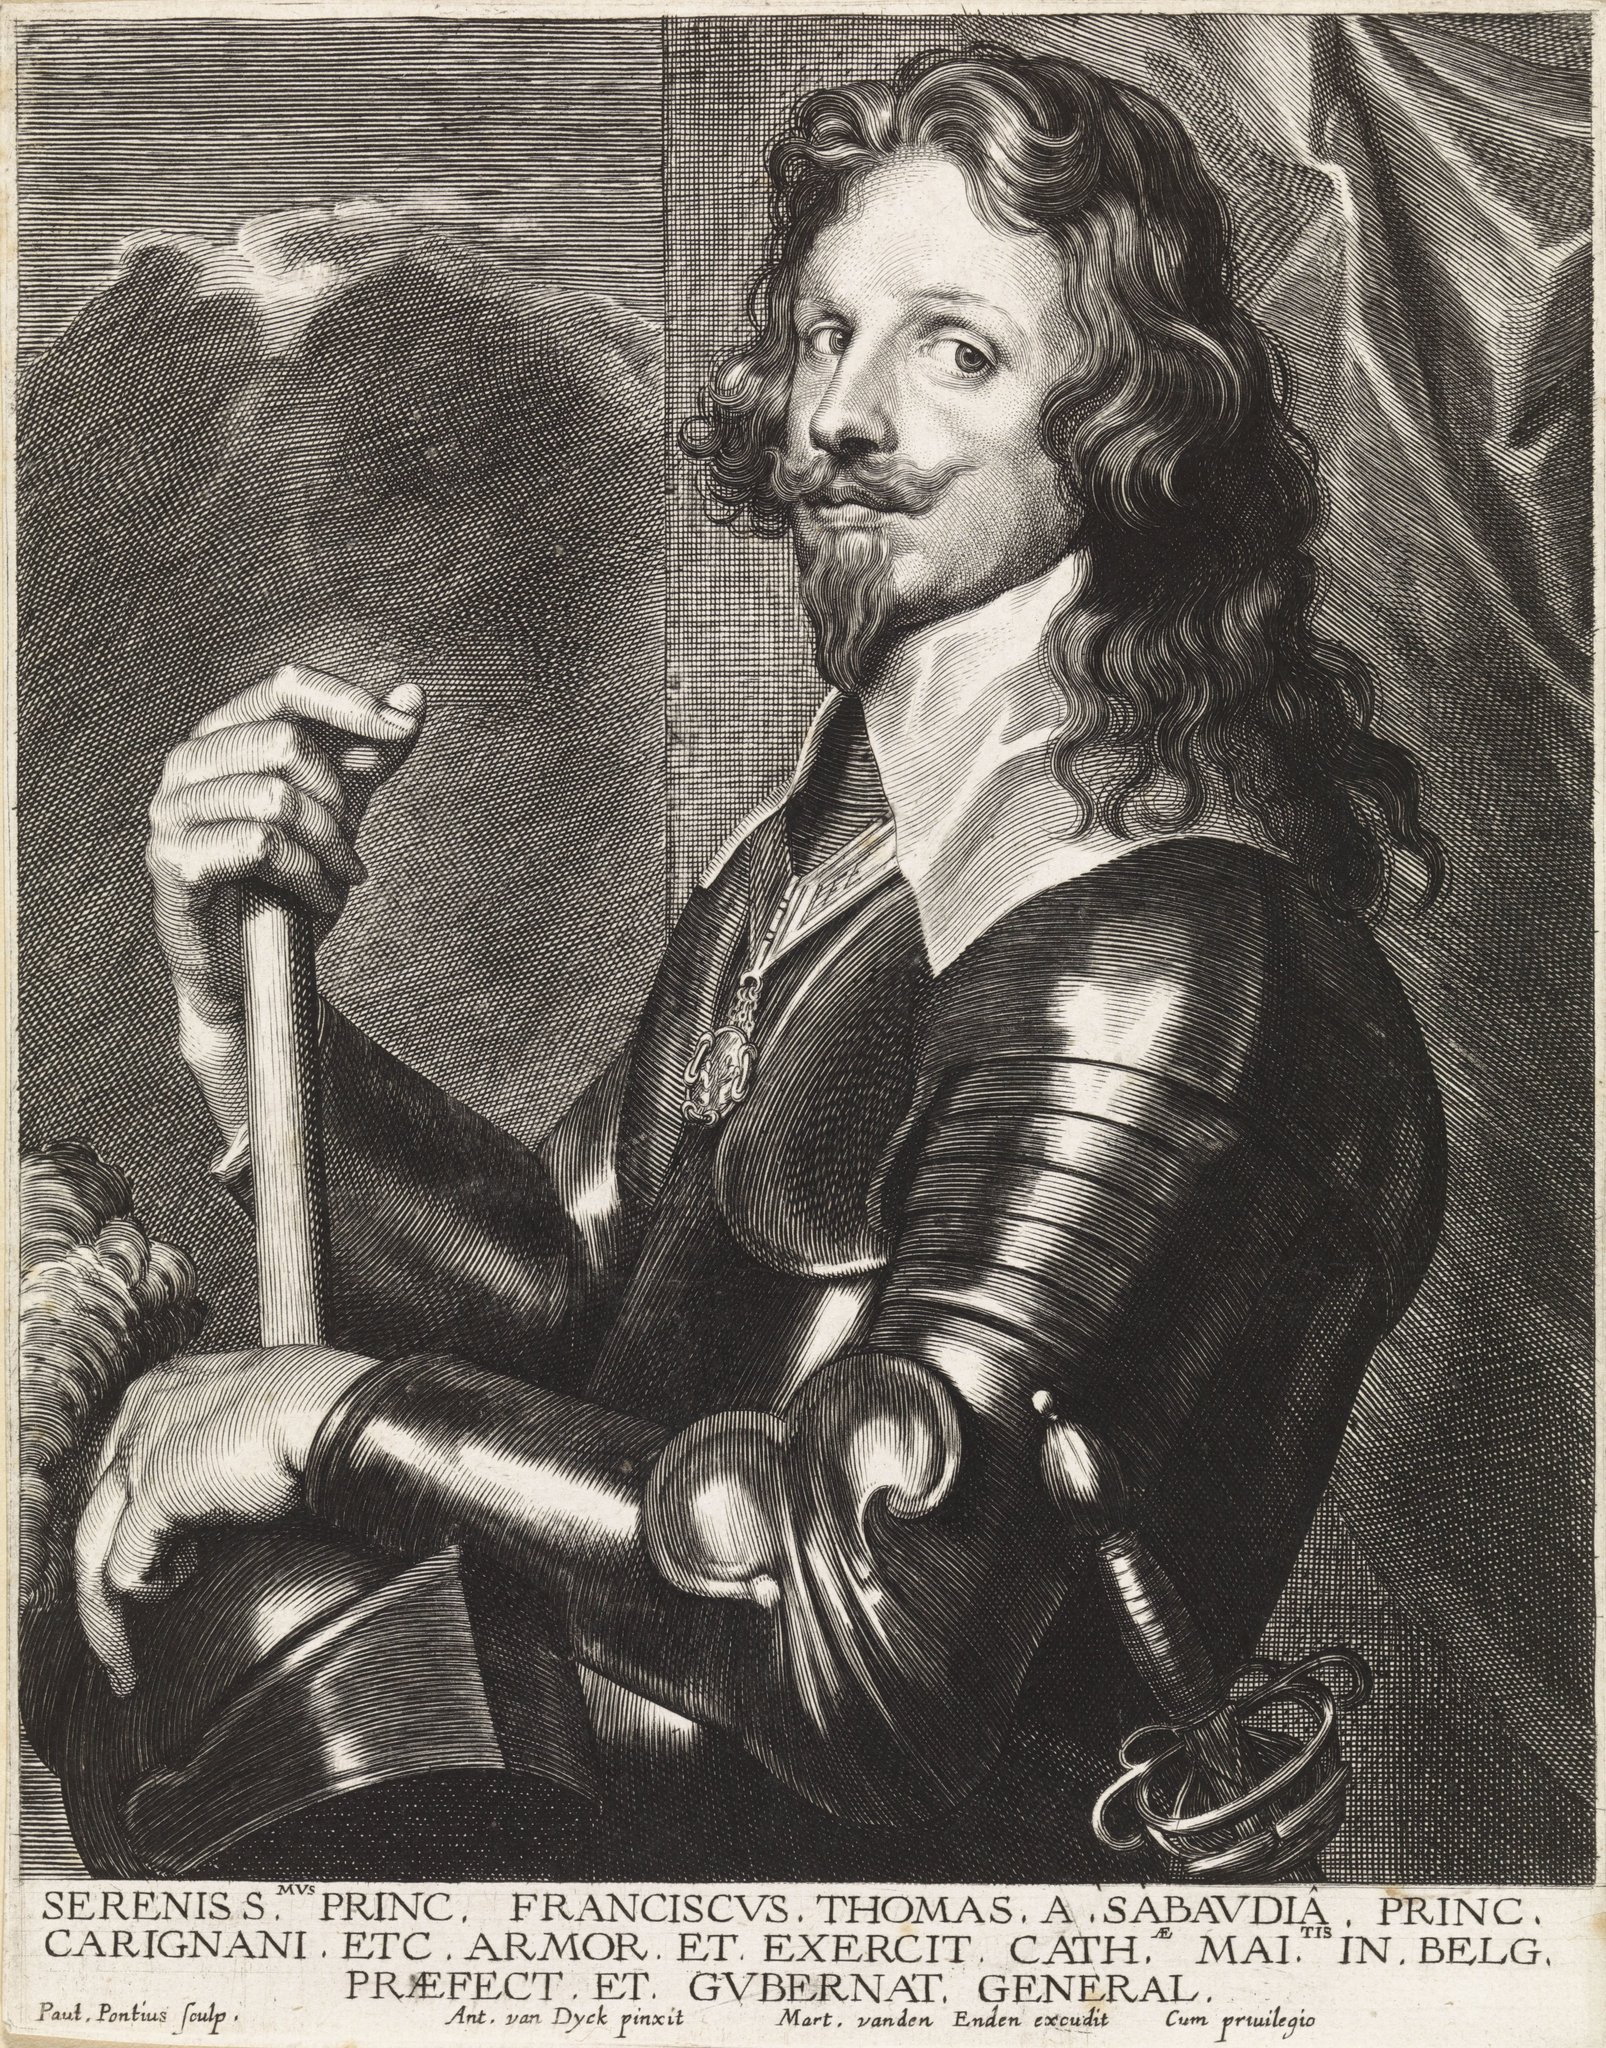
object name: print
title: Portret van Tommaso Francesco, prins van Savoye-Carignano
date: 1616-1657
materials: paper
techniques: engraving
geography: antwerp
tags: knighthood order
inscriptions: collector's mark: Lugt 240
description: Hij draagt een keten met de Hoogste Orde van de Verkondiging.